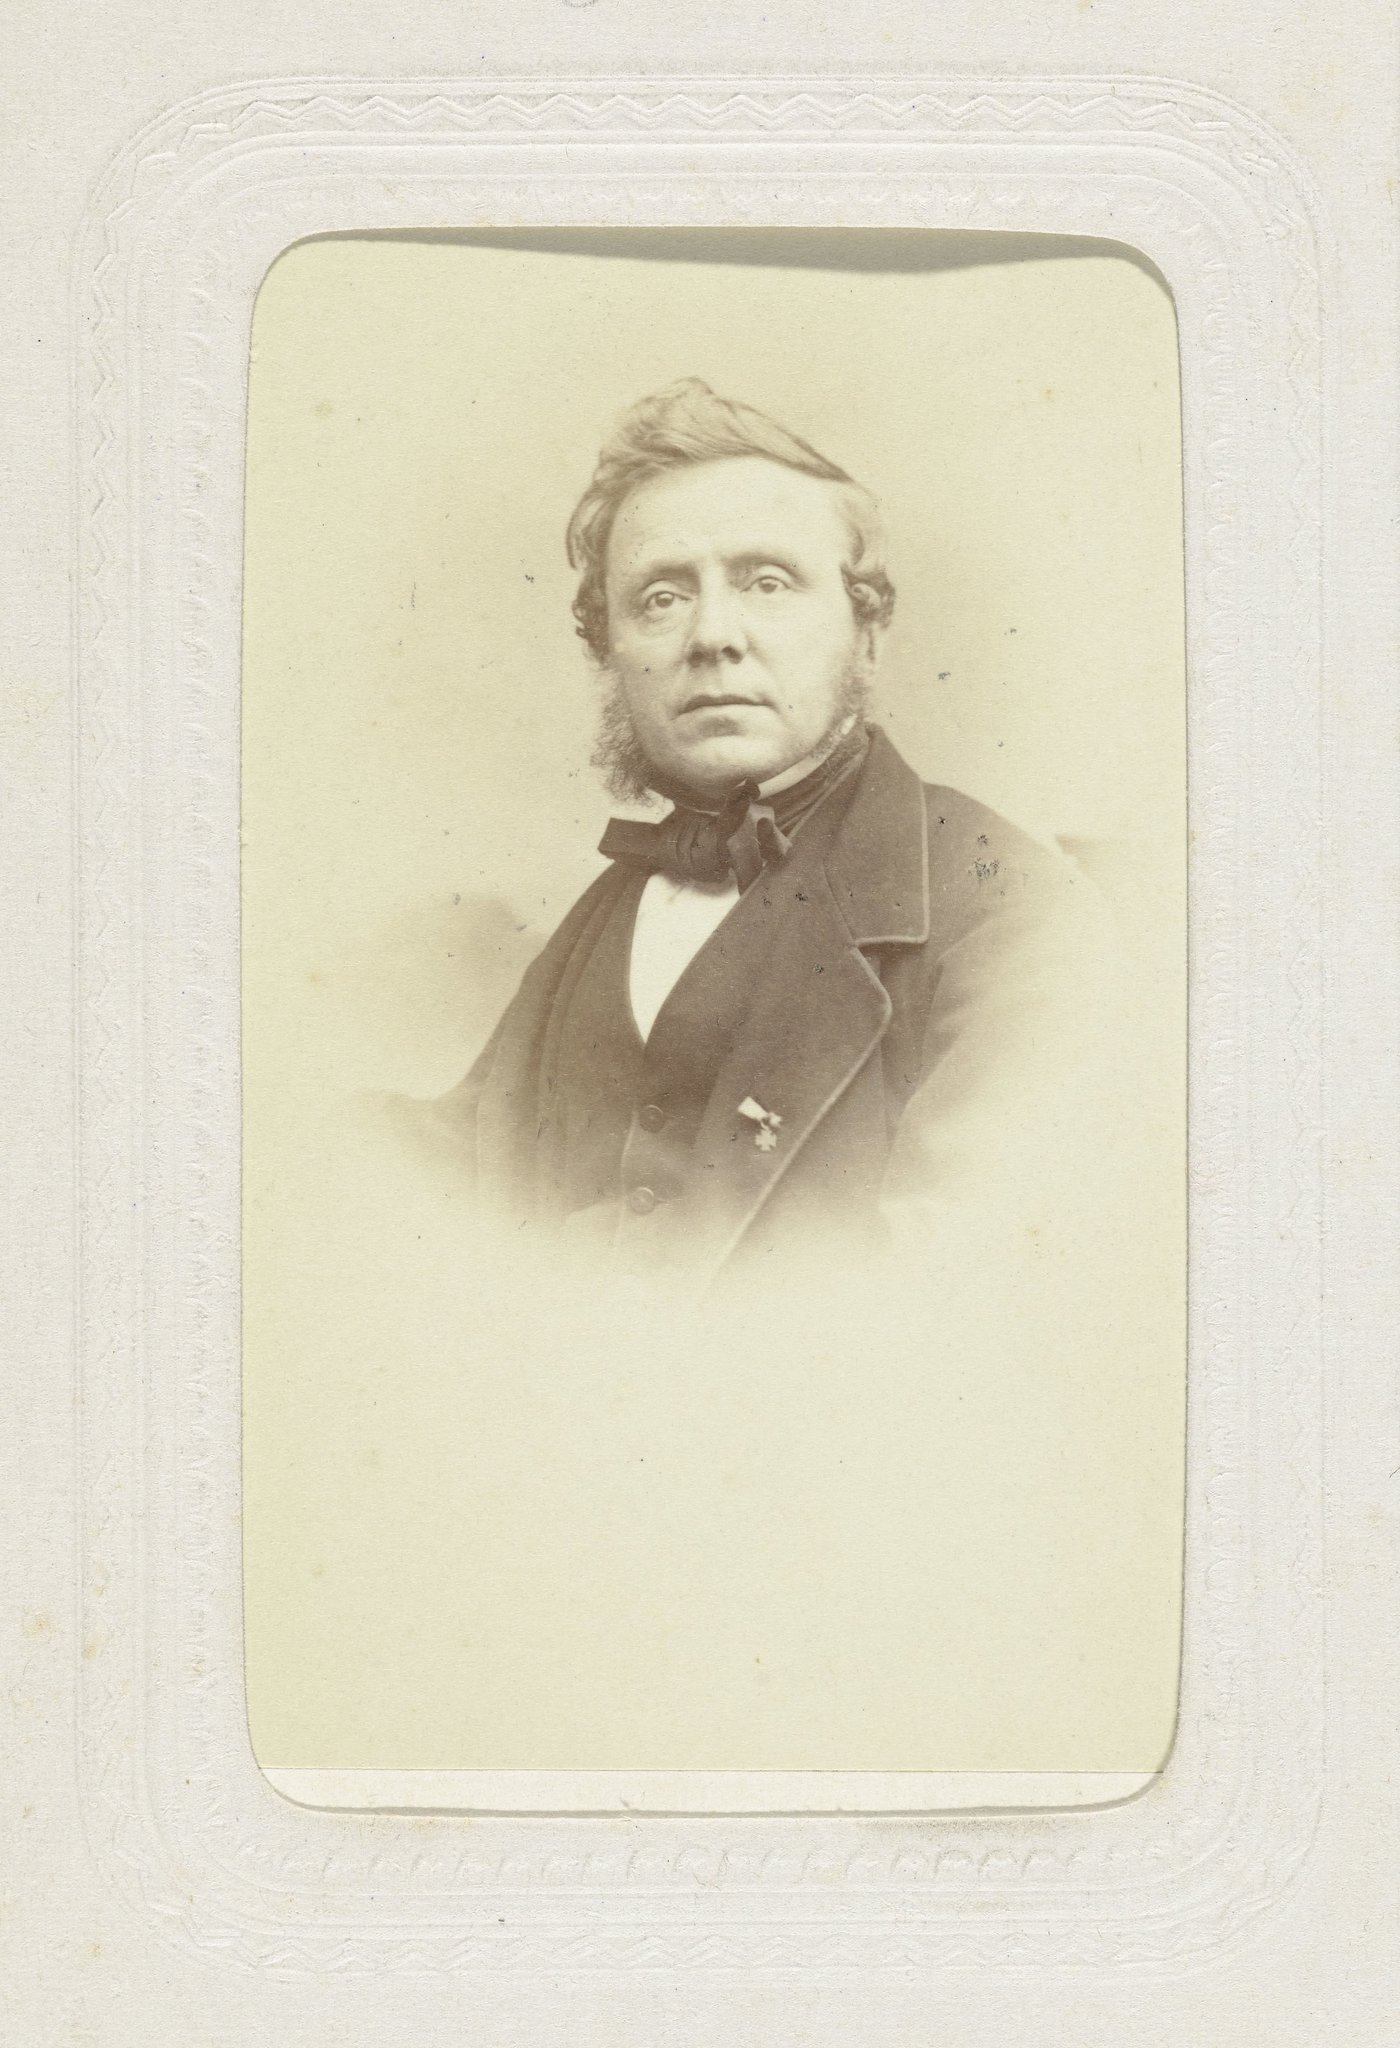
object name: carte de visite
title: Studioportret van R.J. Momme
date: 1863-1866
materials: cardboard, paper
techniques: albumen print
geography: amsterdam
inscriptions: title: ‘1863, R.J. Momme, geb 28 nov. 1811’